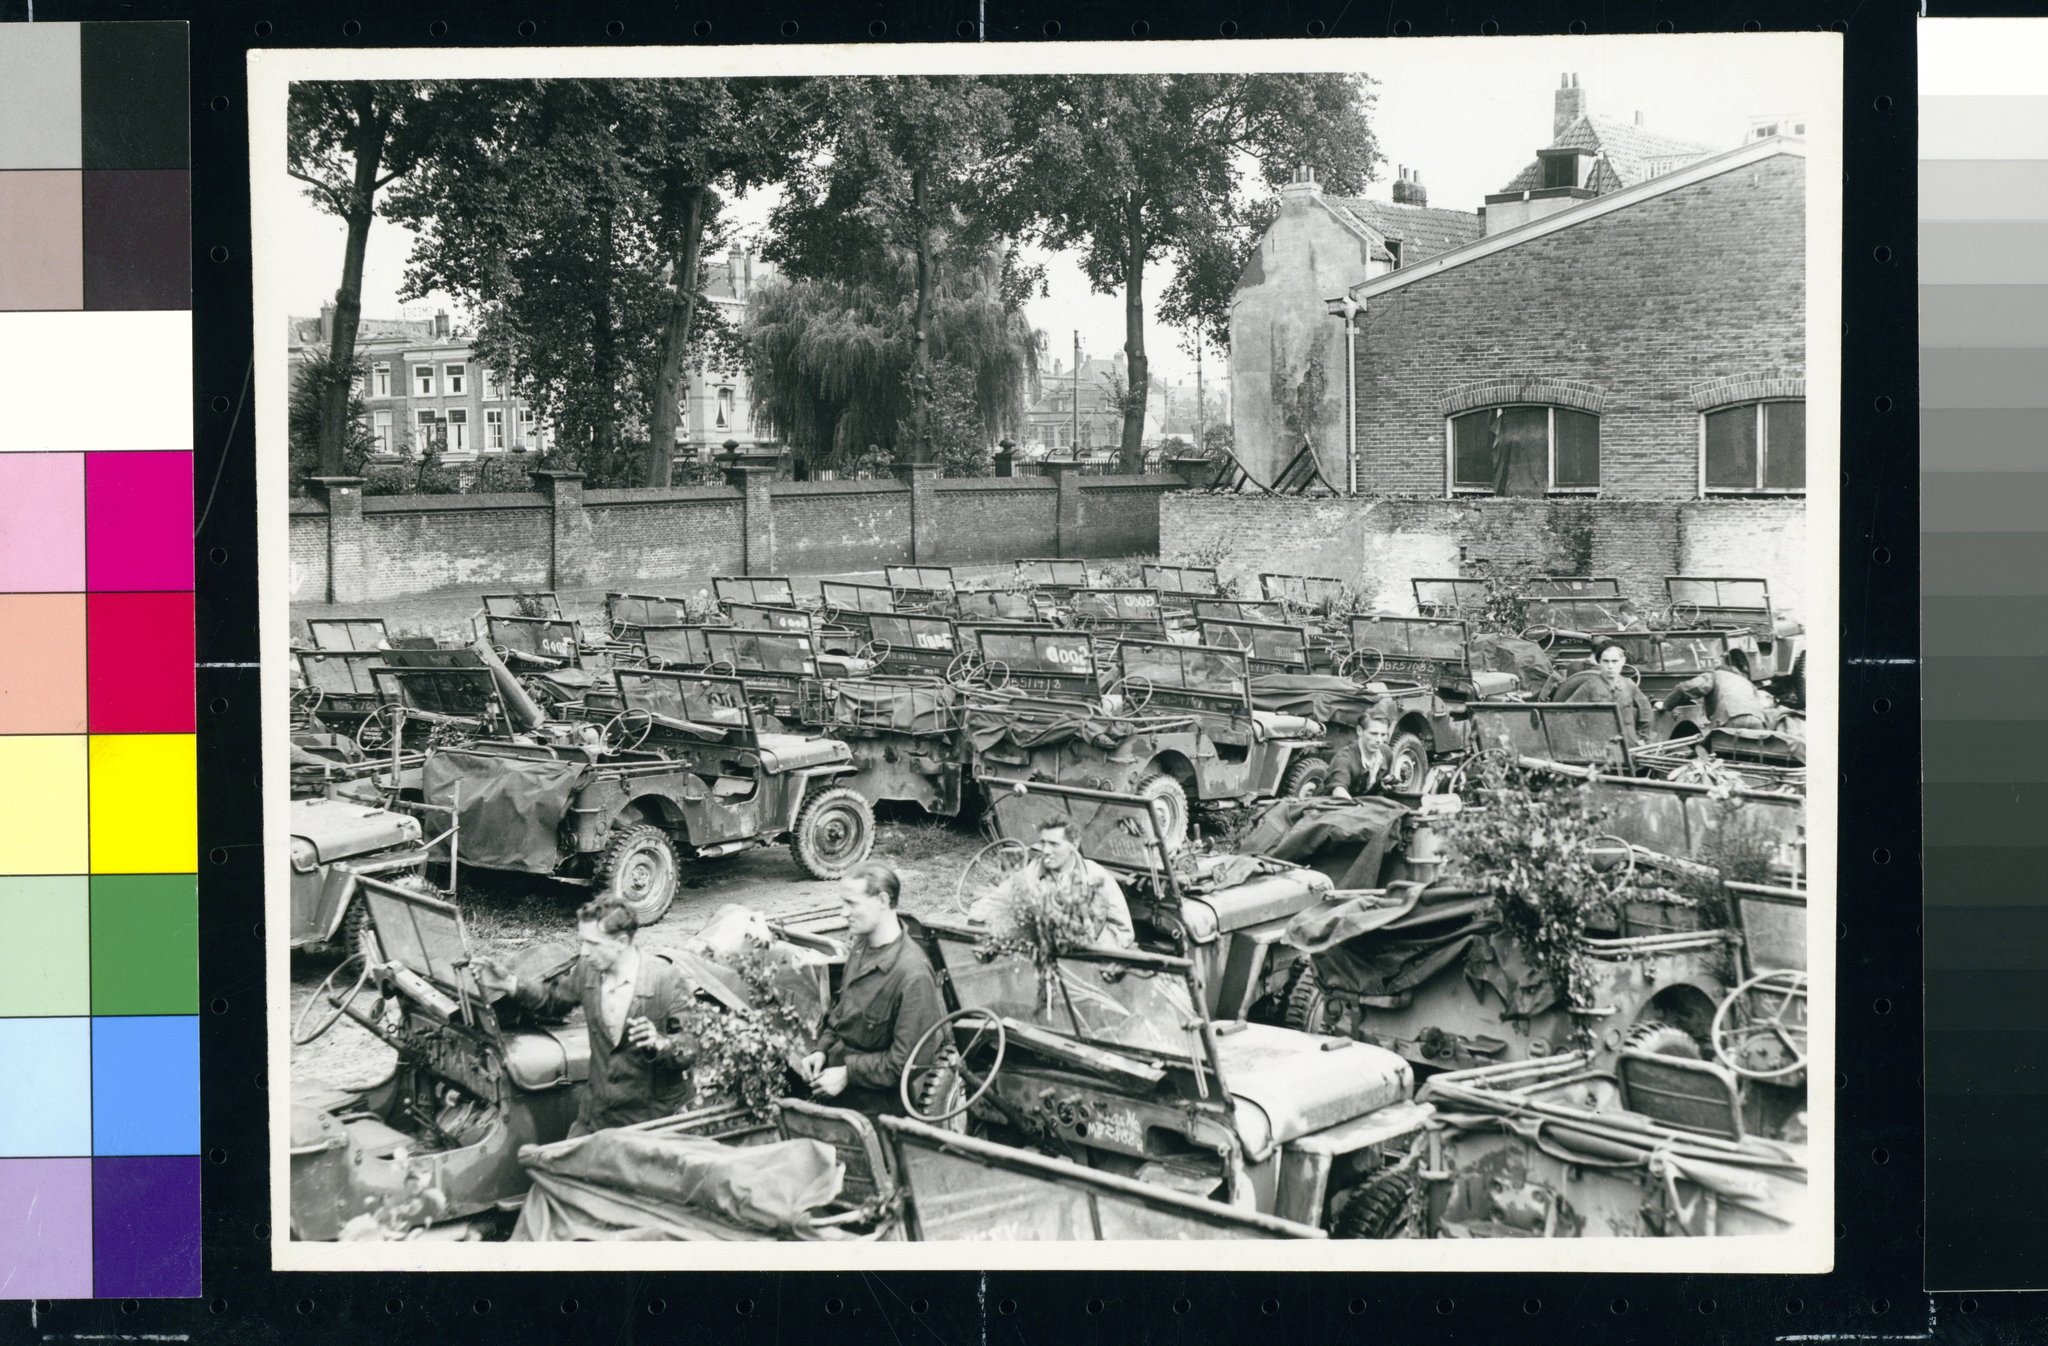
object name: documentary photograph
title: Hulp uit USA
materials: photographic support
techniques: photography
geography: the hague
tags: the hague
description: 75 Jeeps uit de USA zijn aangekomen in Den Haag.